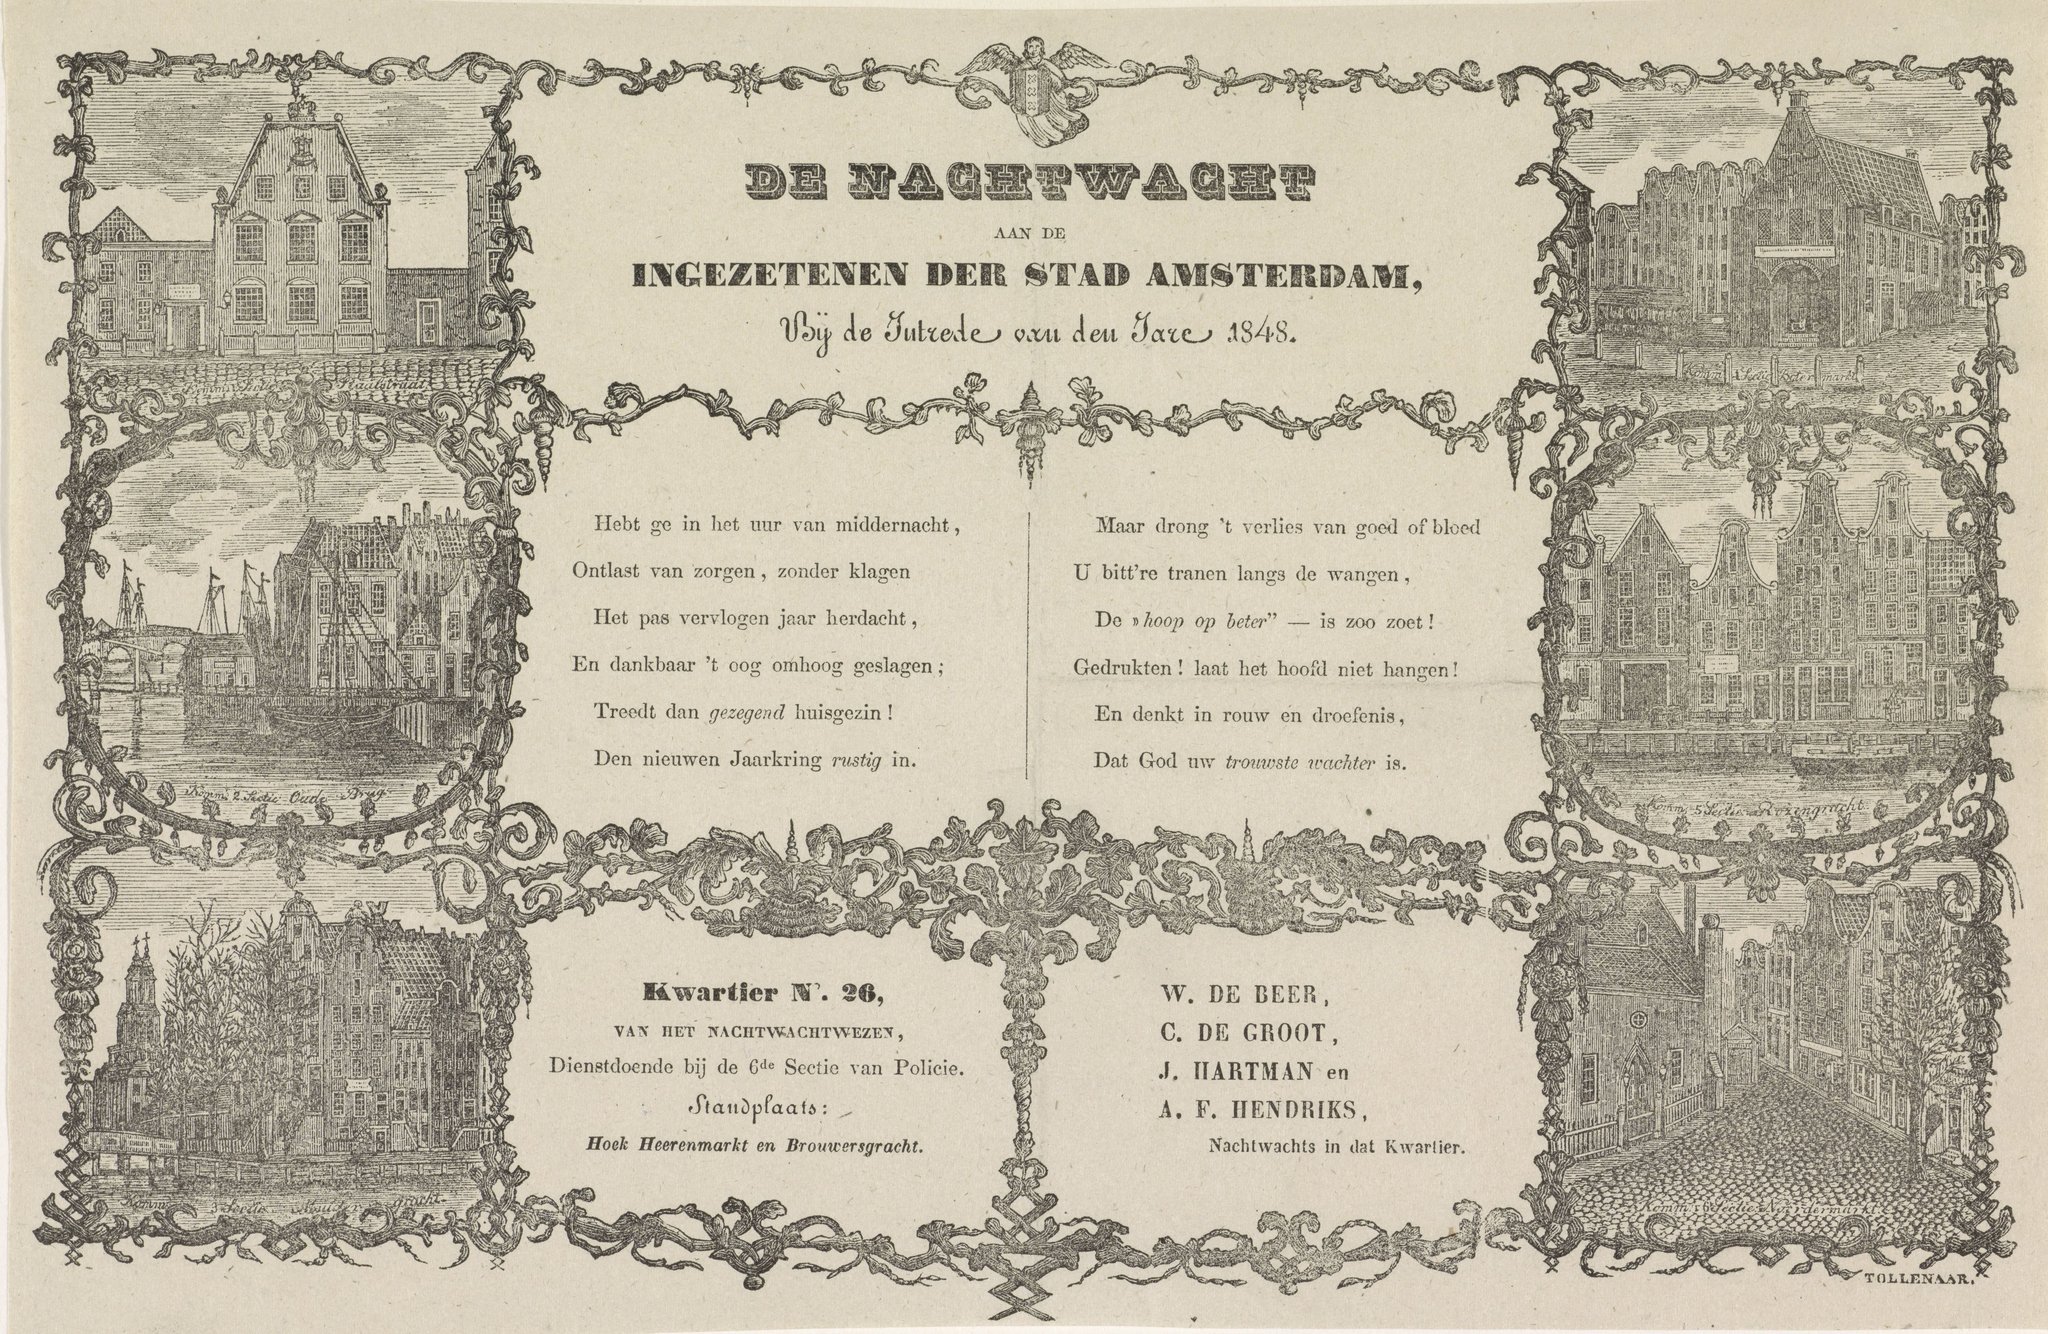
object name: new year card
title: Nieuwjaarswens van de Amsterdamse nachtwacht voor het jaar 1848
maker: dirk wijbrand tollenaar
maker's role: print maker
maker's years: 1808-1858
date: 1847-1848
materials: paper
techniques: letterpress printing, engraving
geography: amsterdam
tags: night patrol, façade (of house or building), street, amsterdam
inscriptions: collector's mark: Lugt 2228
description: Nieuwjaarswens van de Amsterdamse nachtwacht (ratelwacht) voor het jaar 1848. Centraal een gedicht in twee kolommen, aan weerszijden zes gezichten op de sectiebureaus Amsterdam: Staalstraat, Oude Brug, Muidergracht, Botermarkt, Rozengracht en Noordermarkt. Namens de nachtwacht in kwartier No. 26 van het nachtwachtwezen dienstdoende bij de 6e Sectie van Policie: W. de Beer, C. de Groot, J. Hartman en A.F. Hendriks.